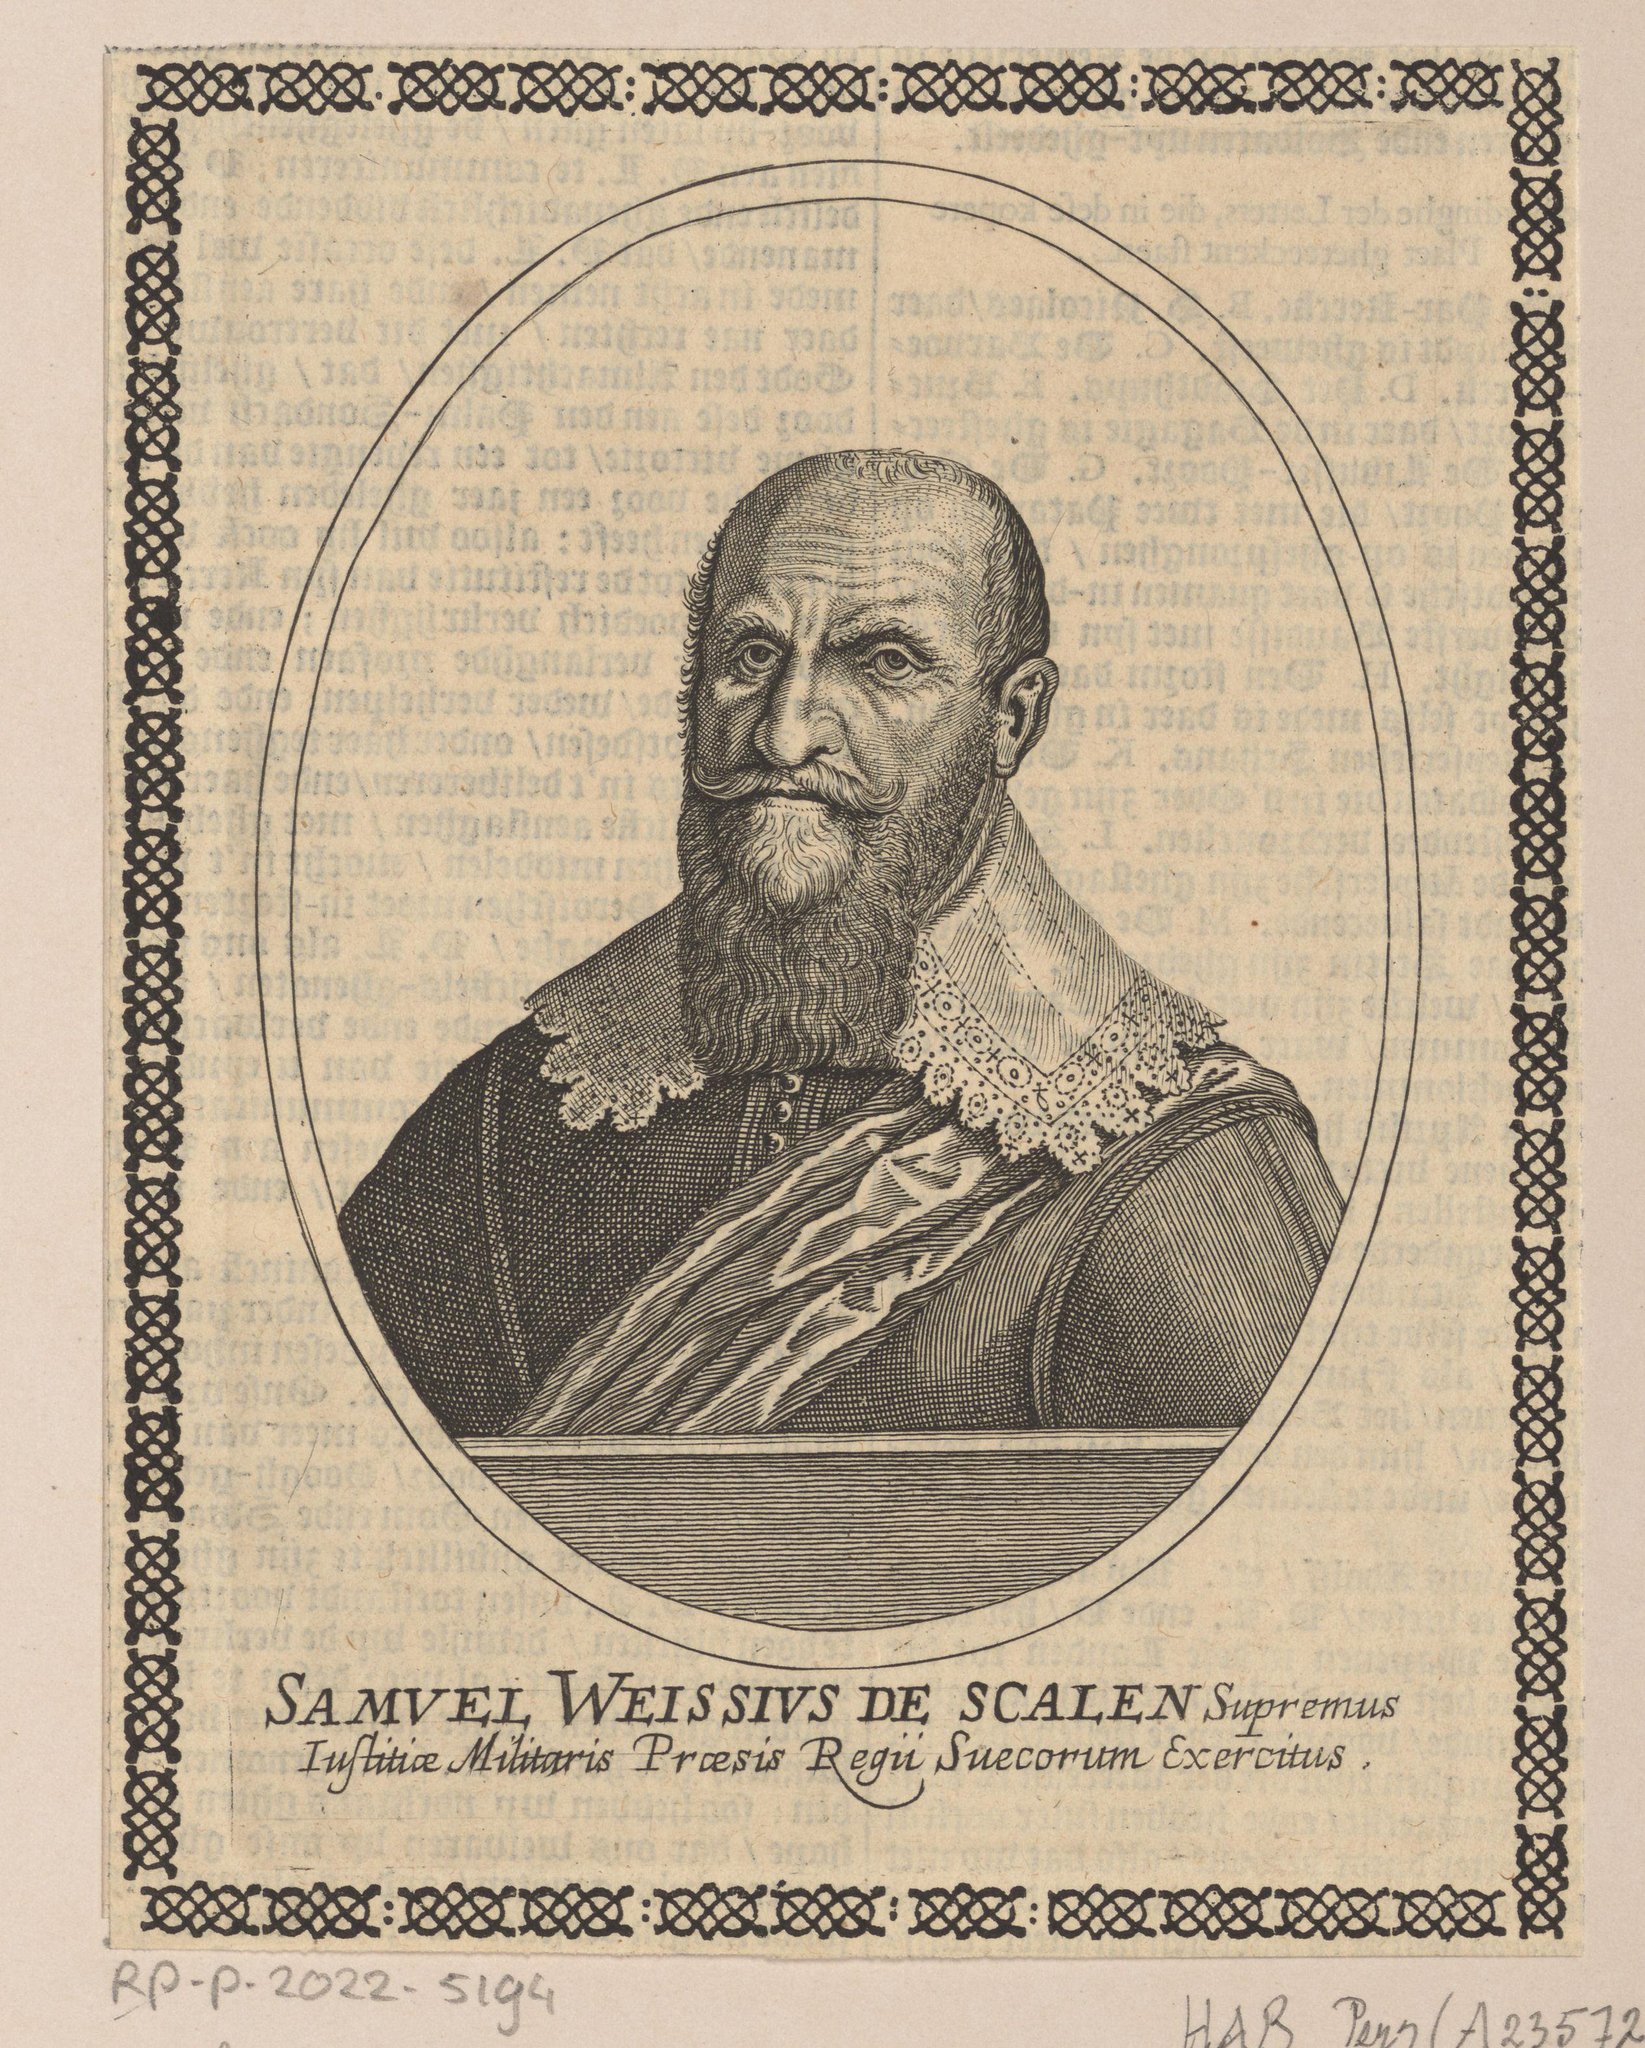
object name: print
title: Portret van Samuel von Weiss Schal'en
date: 1642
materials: paper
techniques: engraving, letterpress printing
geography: northern netherlands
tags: historical persons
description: Prent uit: Historis oft waerachtich verhael van den gantschen toestant van oorlooge soo die ghevoert is in Duytschlandt (...). Amsterdam: Cornelis Danckerts, 1642.